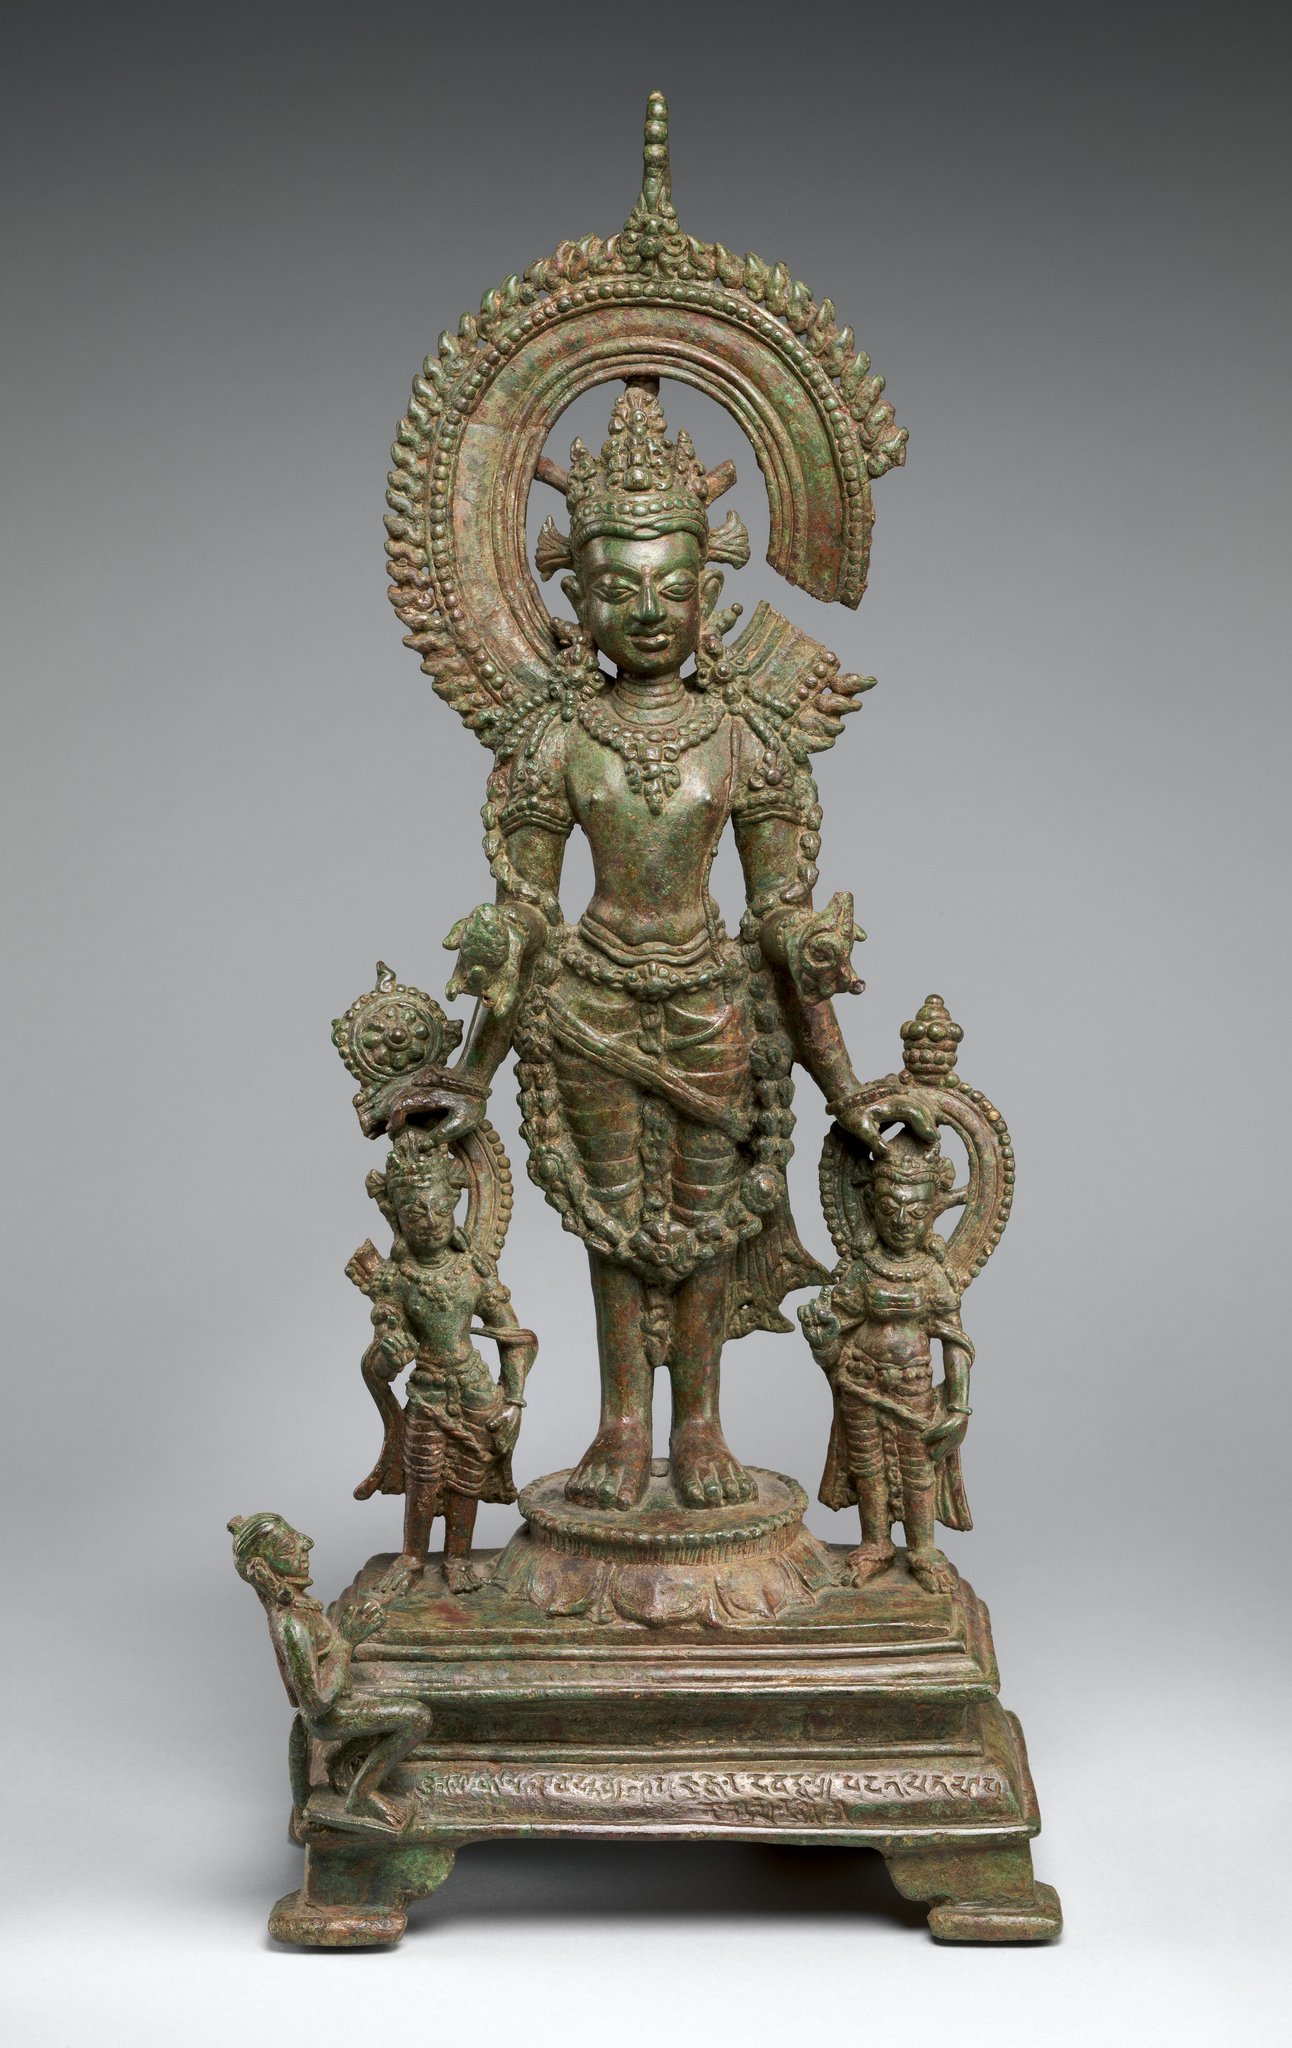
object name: group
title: Vishnu Flanked by His Personified Attributes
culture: indian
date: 801-833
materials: bronze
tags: vishnu,hinduism